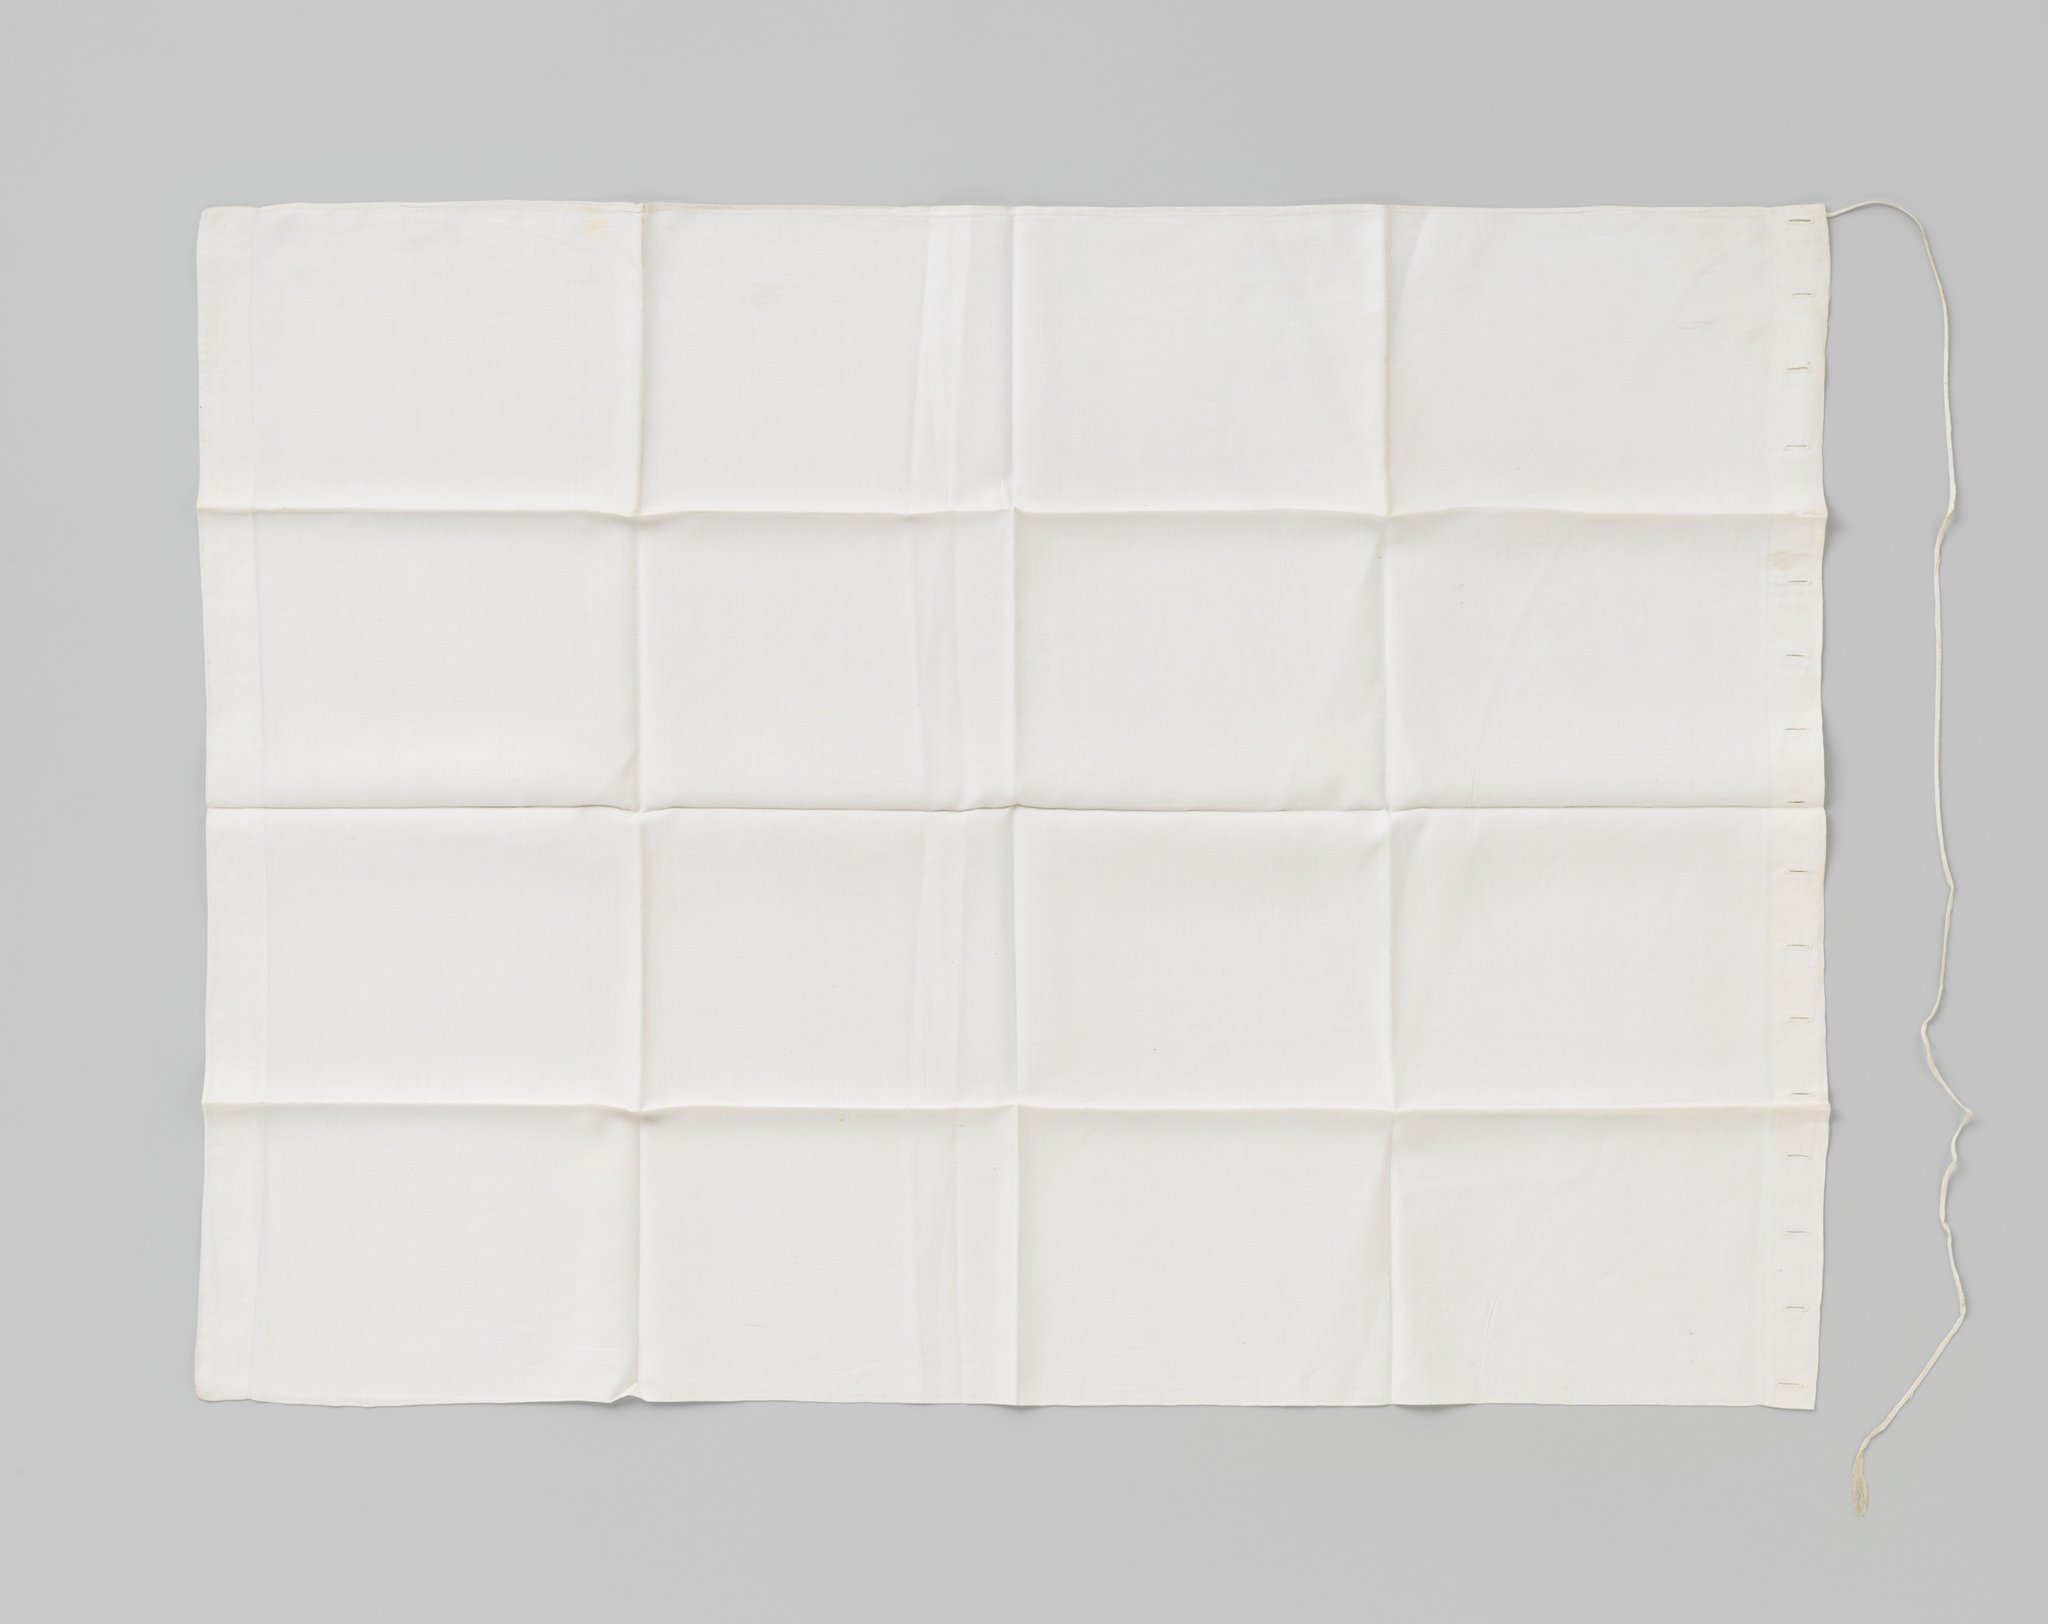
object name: sloop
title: Sloop van wit linnen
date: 1825-1875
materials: linen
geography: northern netherlands